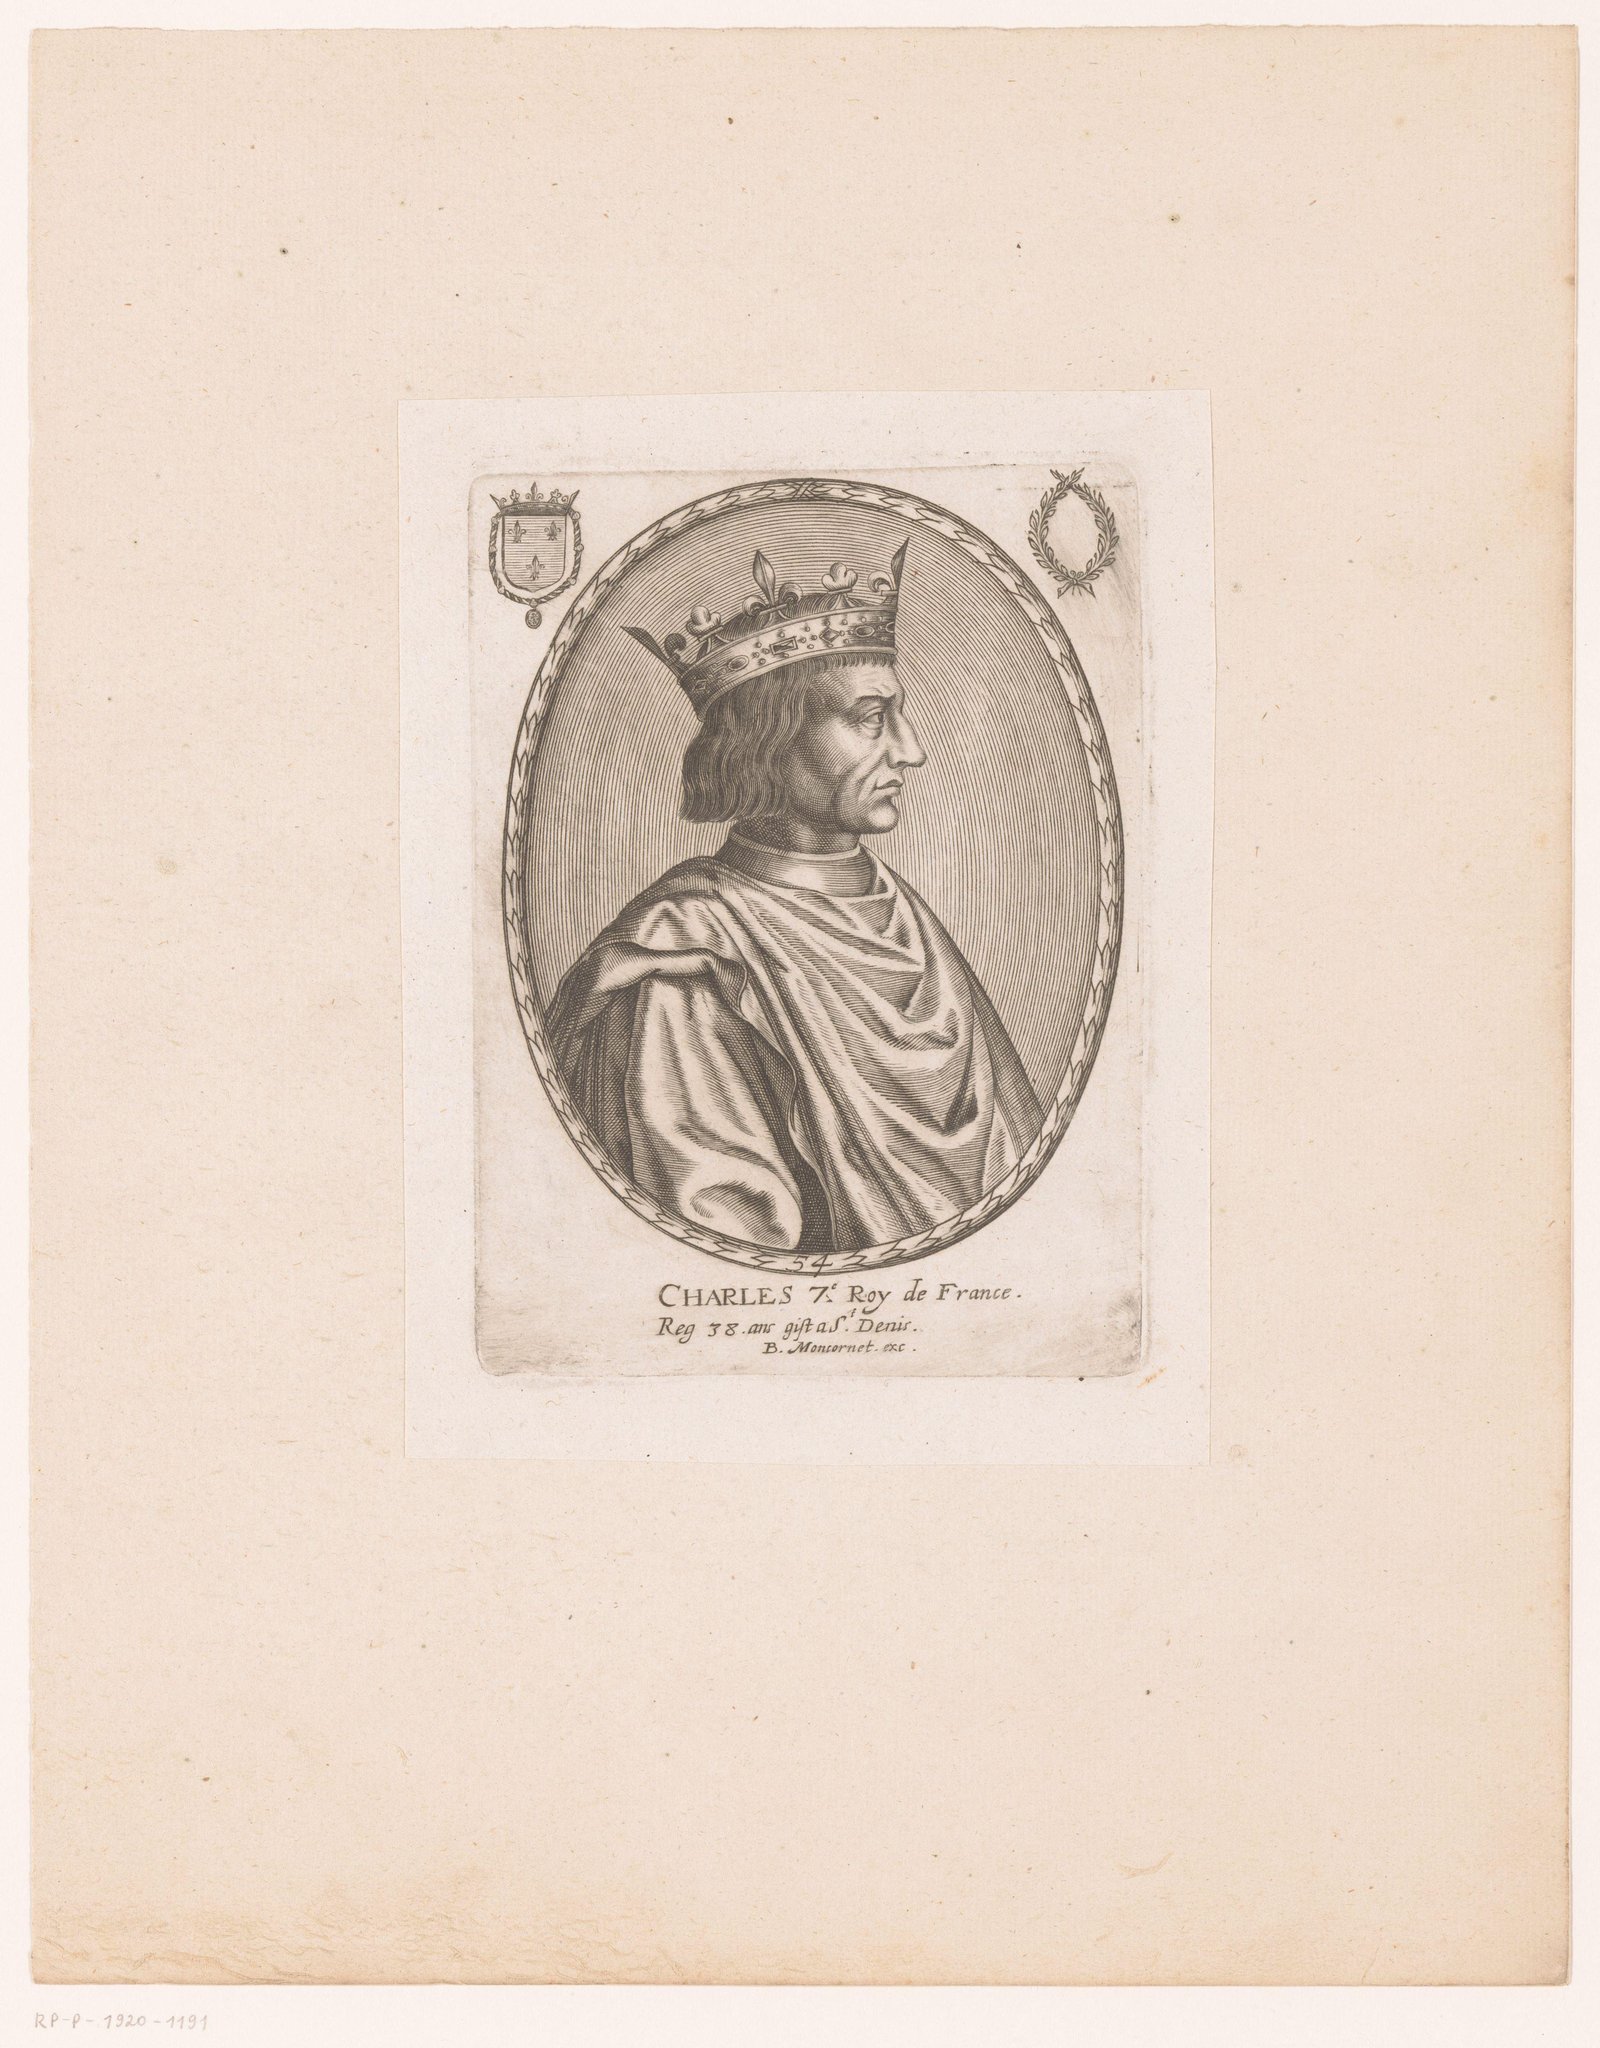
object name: print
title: Portret van Karel VII van Frankrijk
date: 1610-1668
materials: paper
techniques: engraving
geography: paris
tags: paris, historical persons, king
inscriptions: collector's mark: Lugt 2228